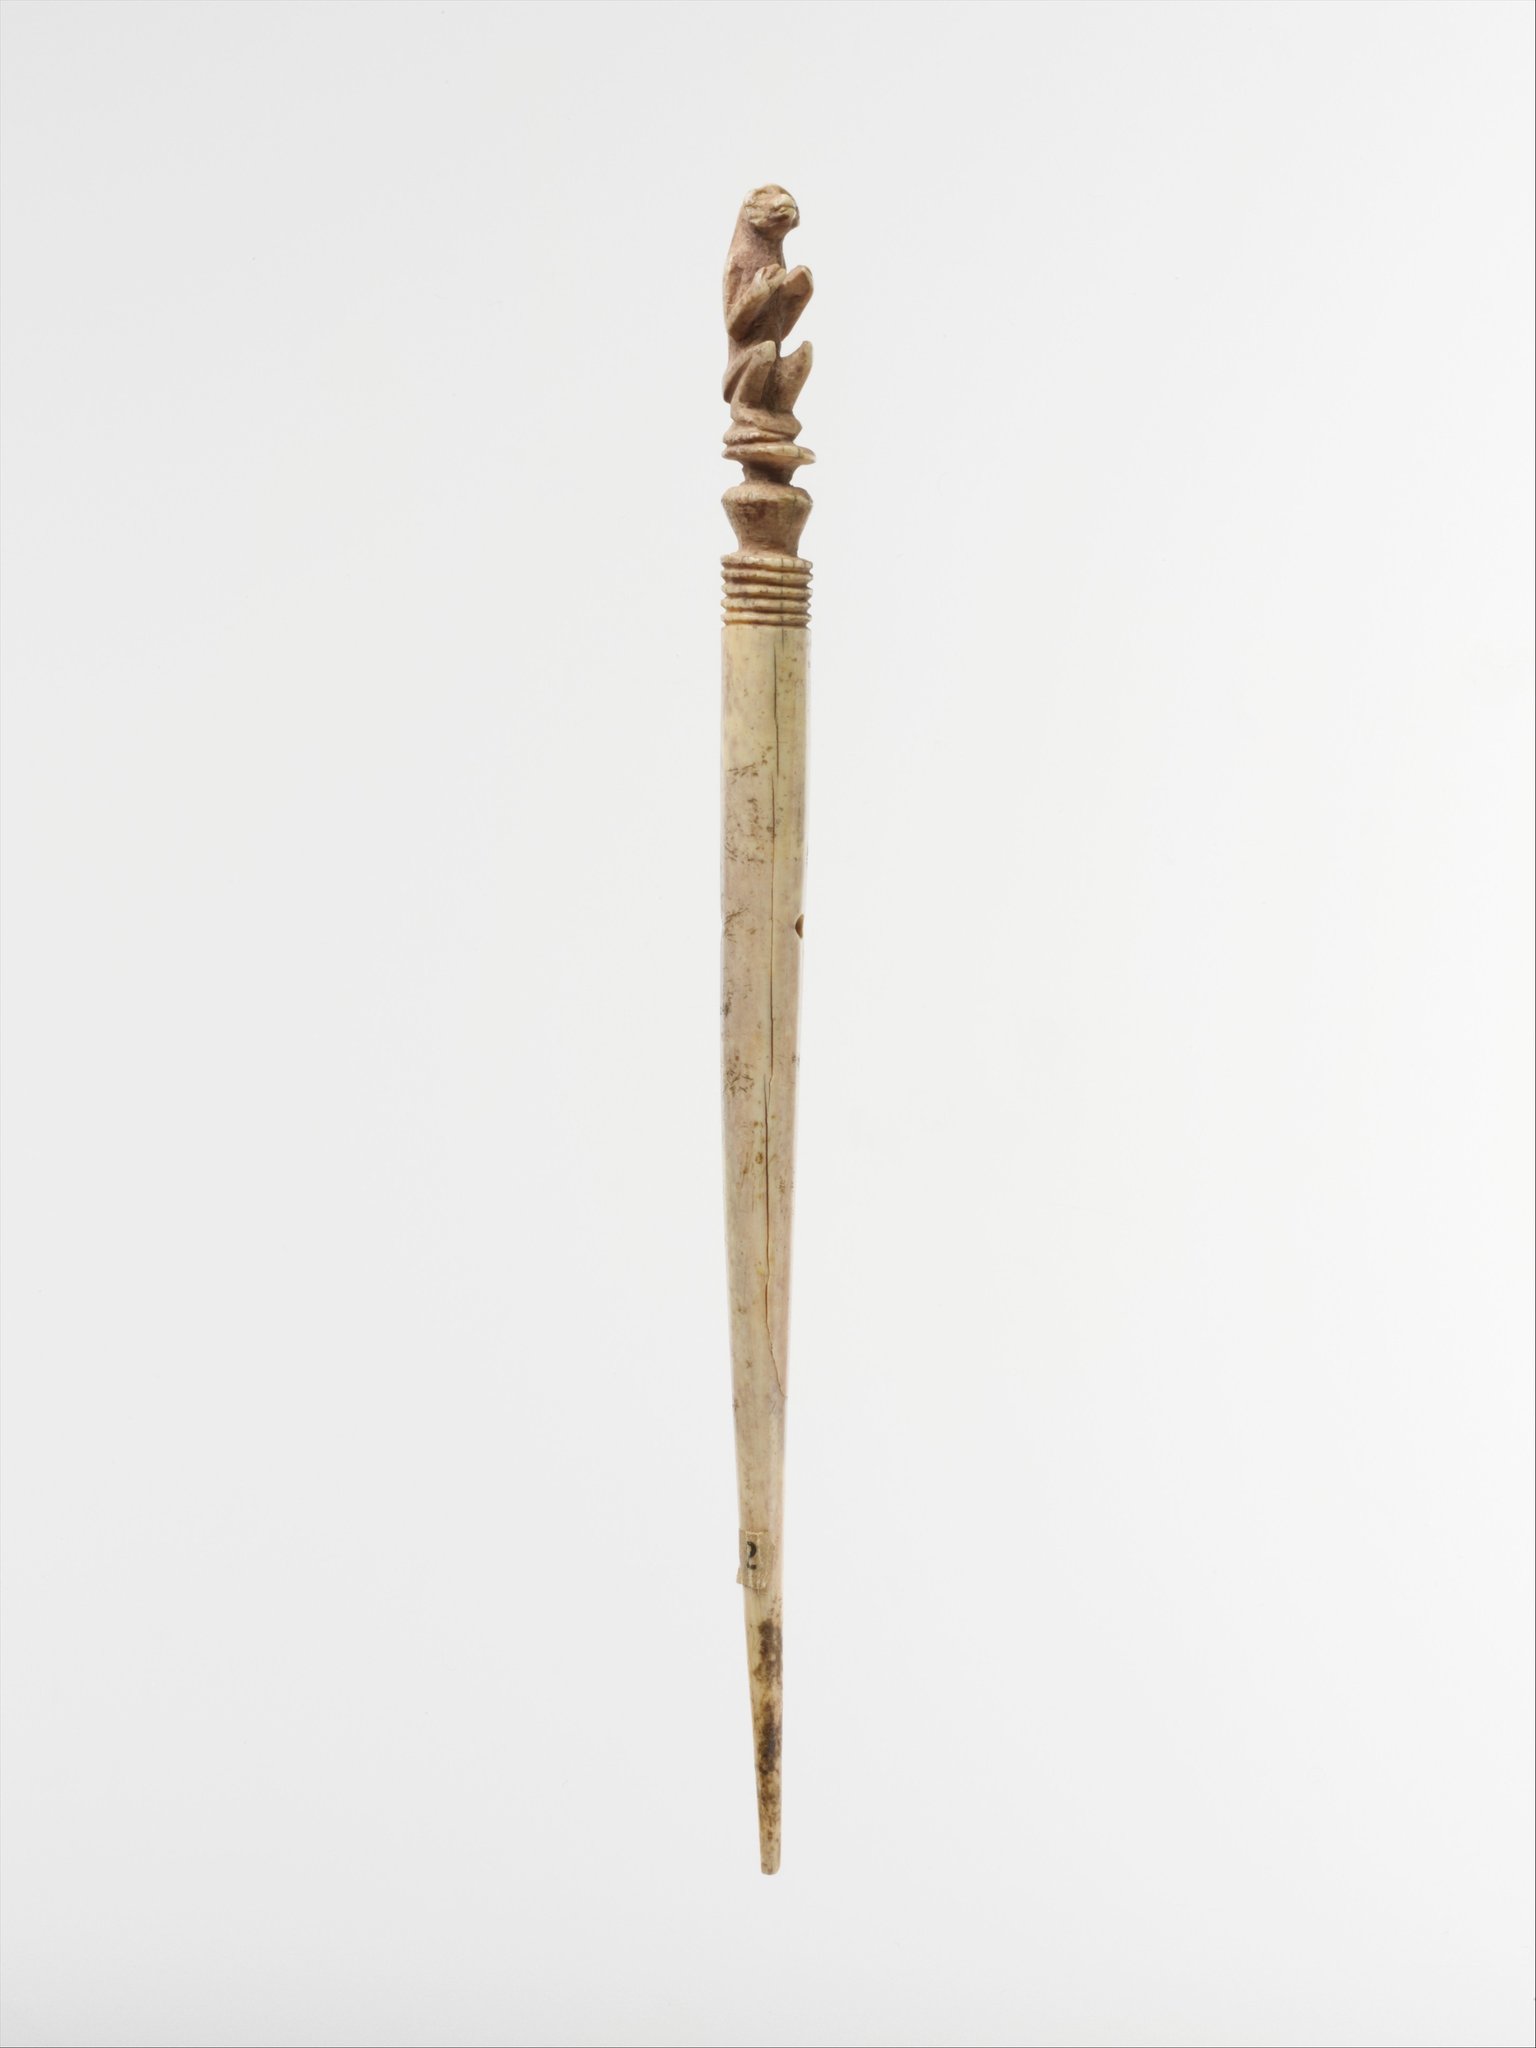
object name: pin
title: Ivory hairpin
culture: roman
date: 1-100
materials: ivory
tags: monkeys